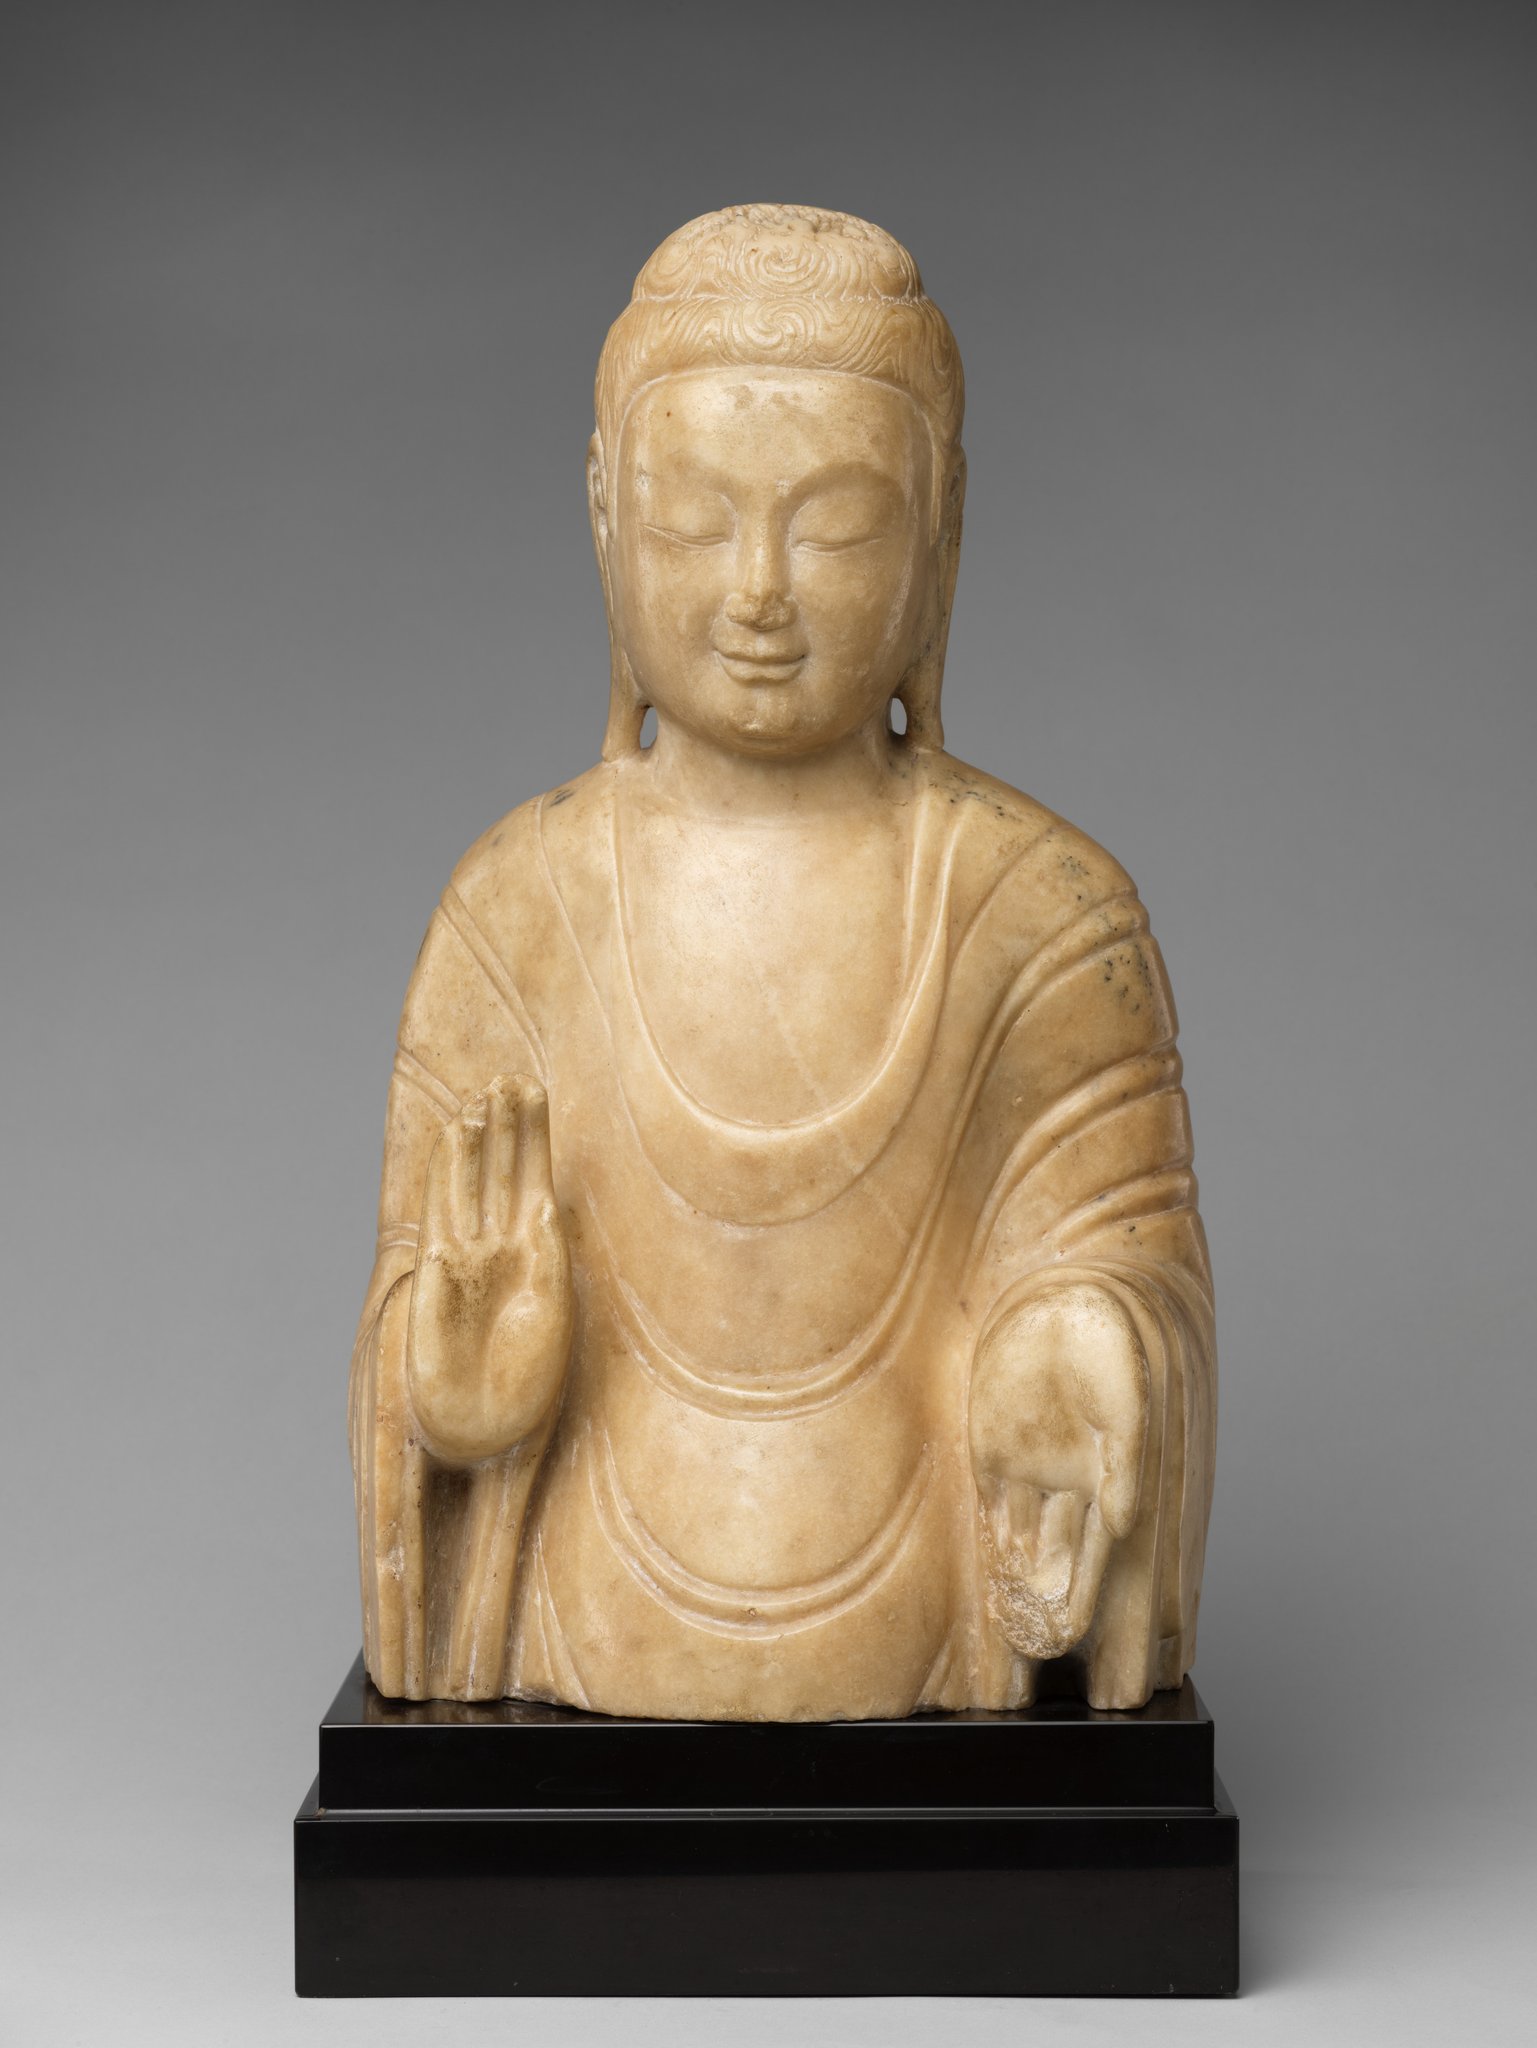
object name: upper half of figure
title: Buddha Shakyamuni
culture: chinese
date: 581-618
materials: marble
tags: buddha